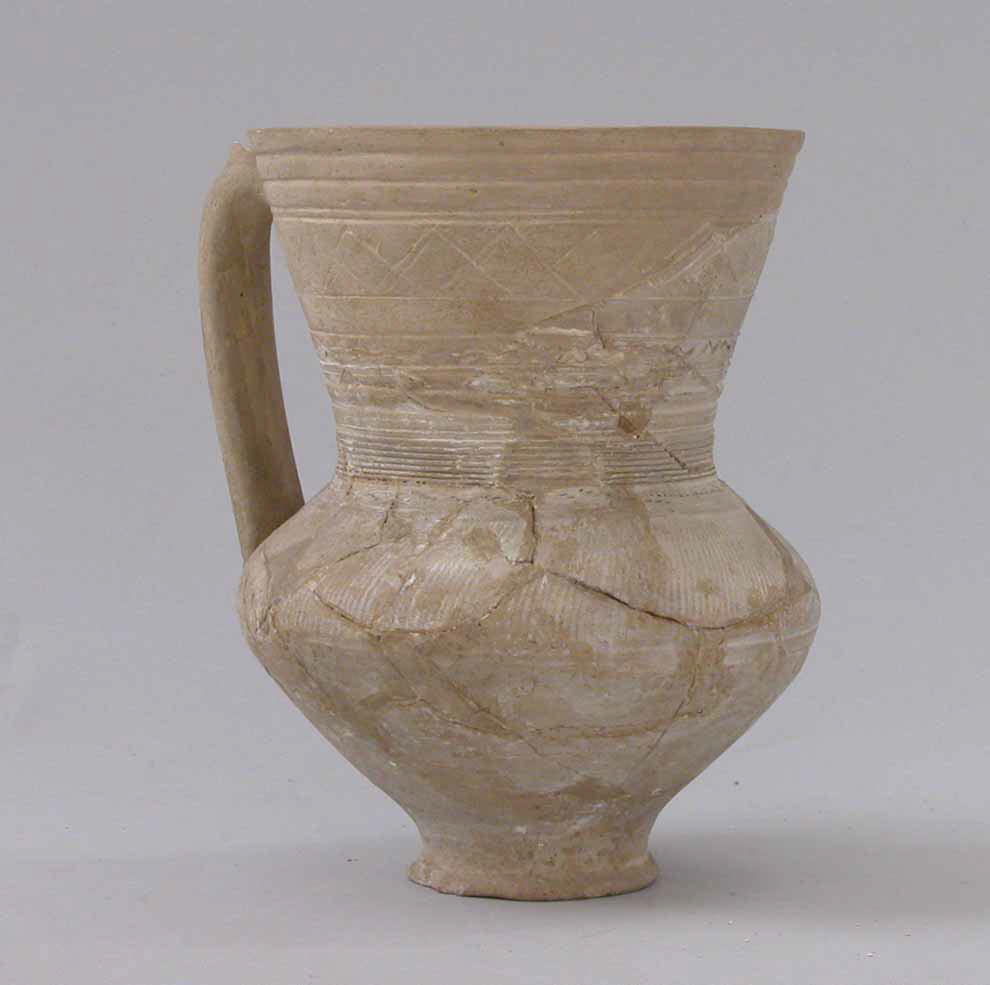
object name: jug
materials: earthenware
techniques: incising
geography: iran